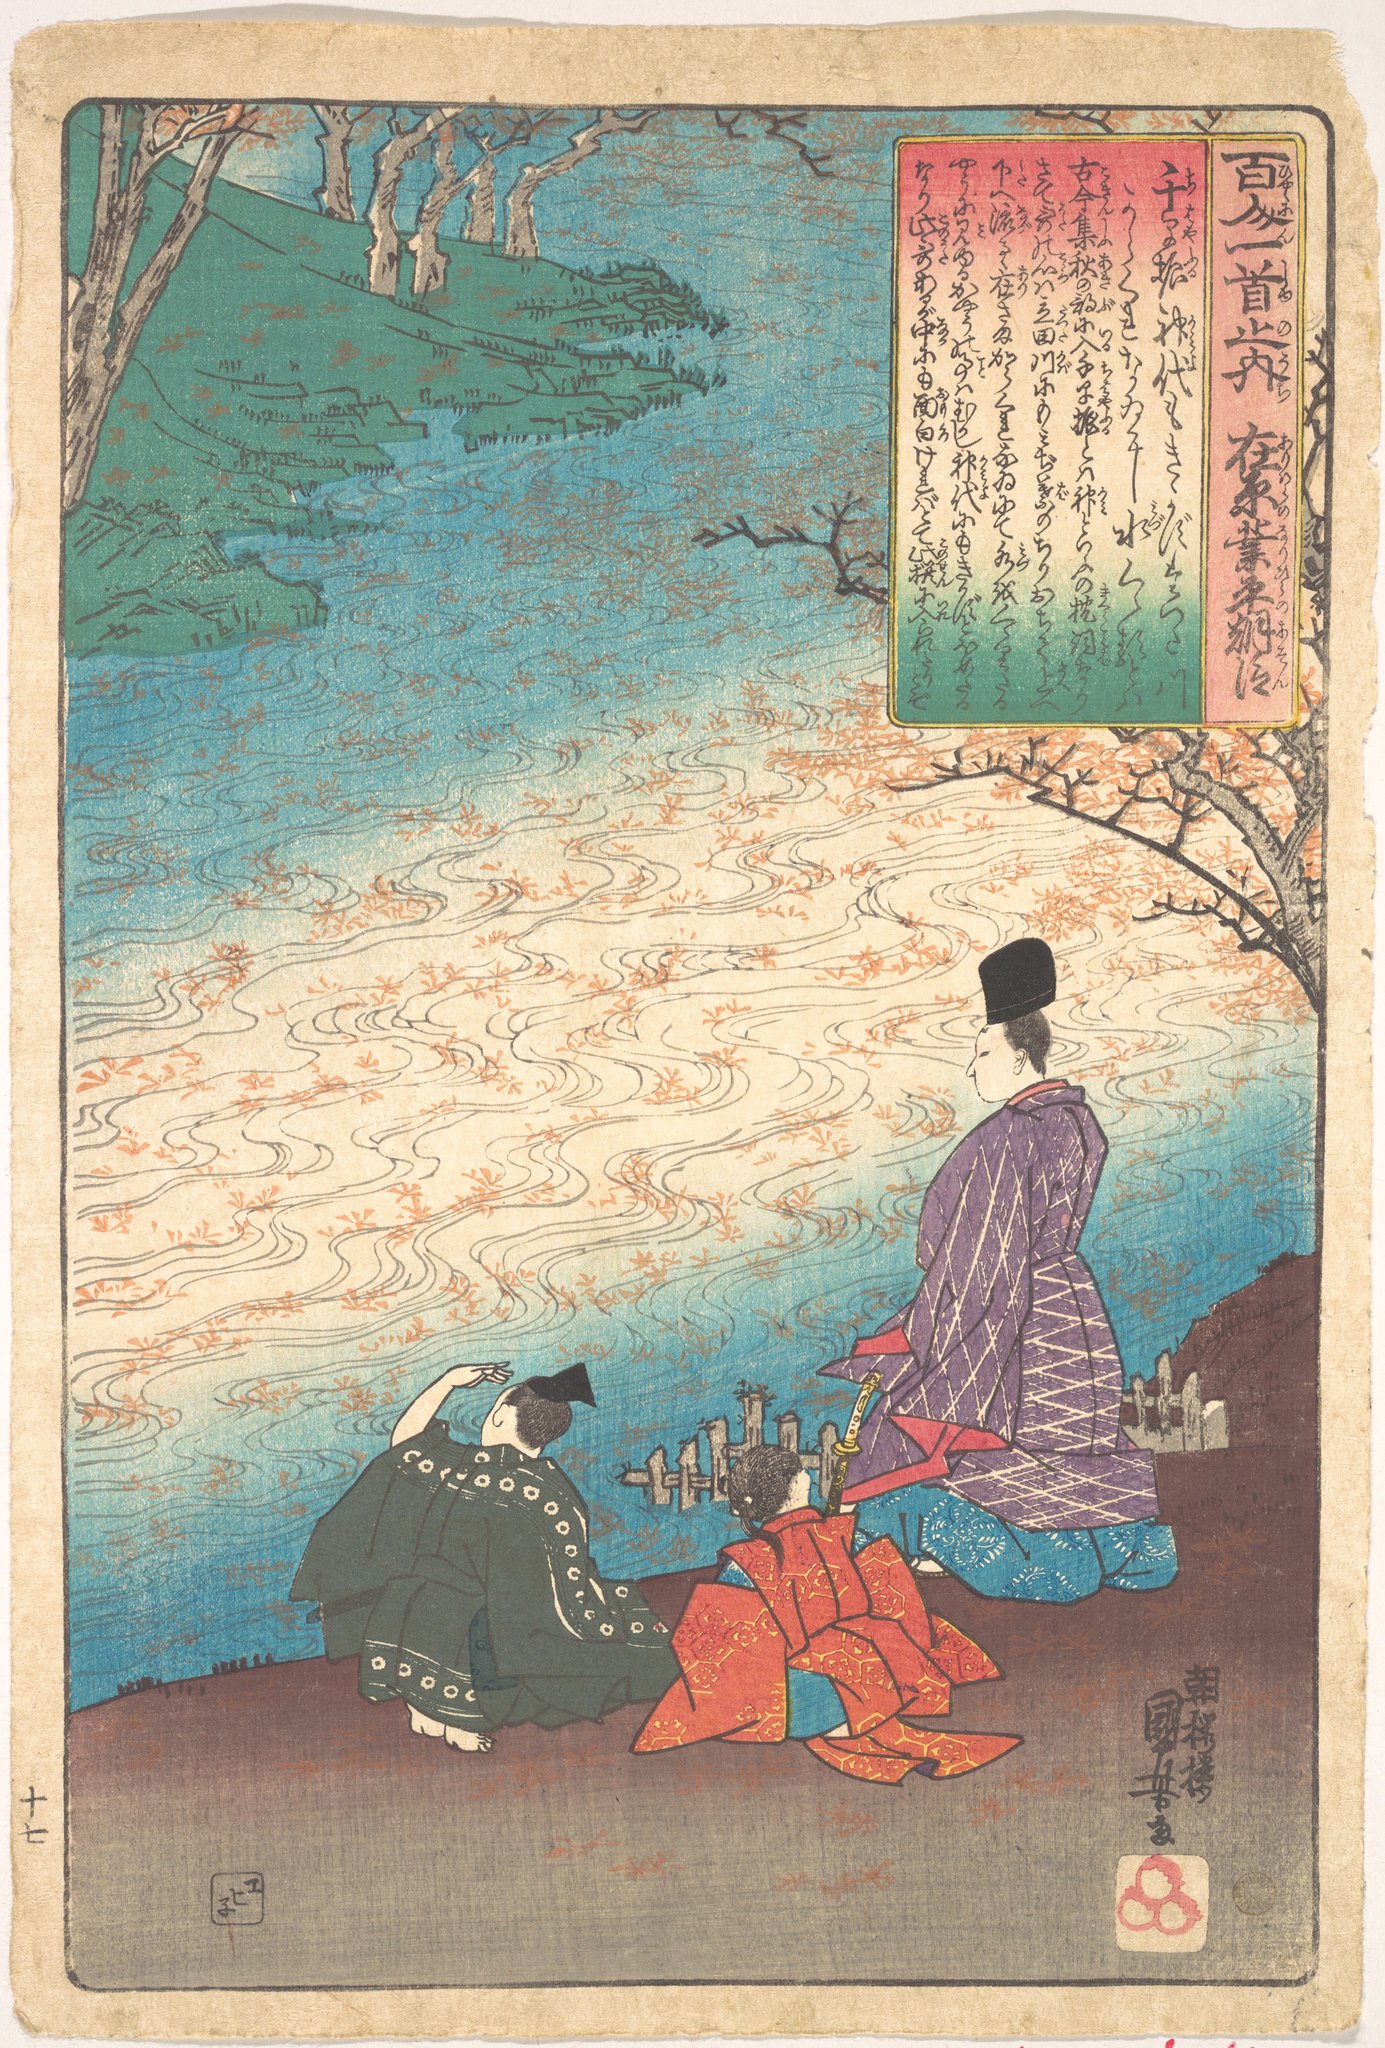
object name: print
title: Poet with Two Pages on the Banks of the Tatsuta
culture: japanese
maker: utagawa kuniyoshi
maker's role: artist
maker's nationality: japanese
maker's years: 1797-1861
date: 1845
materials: ink, paper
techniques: woodblock print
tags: human figures,rivers